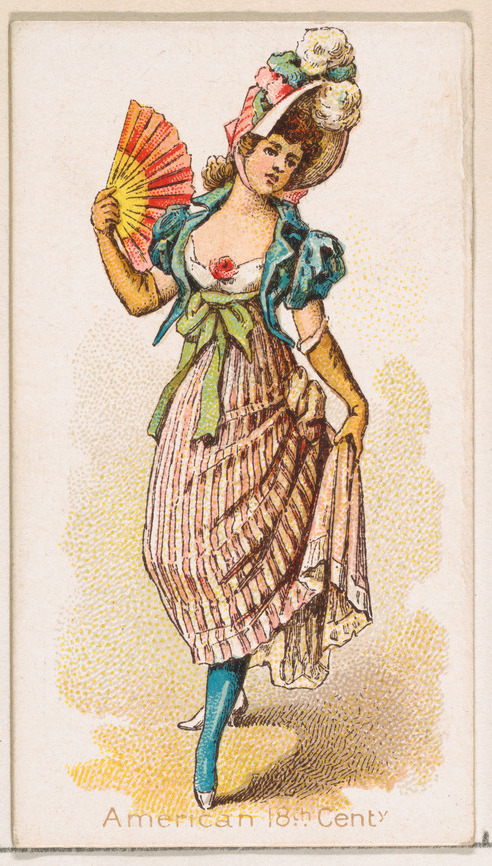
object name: print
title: American 18th Century Dancer, from the Dancing Women series (N186) issued by Wm. S. Kimball & Co.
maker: william s. kimball & company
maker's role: publisher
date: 1889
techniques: color lithograph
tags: fans,women,dancers